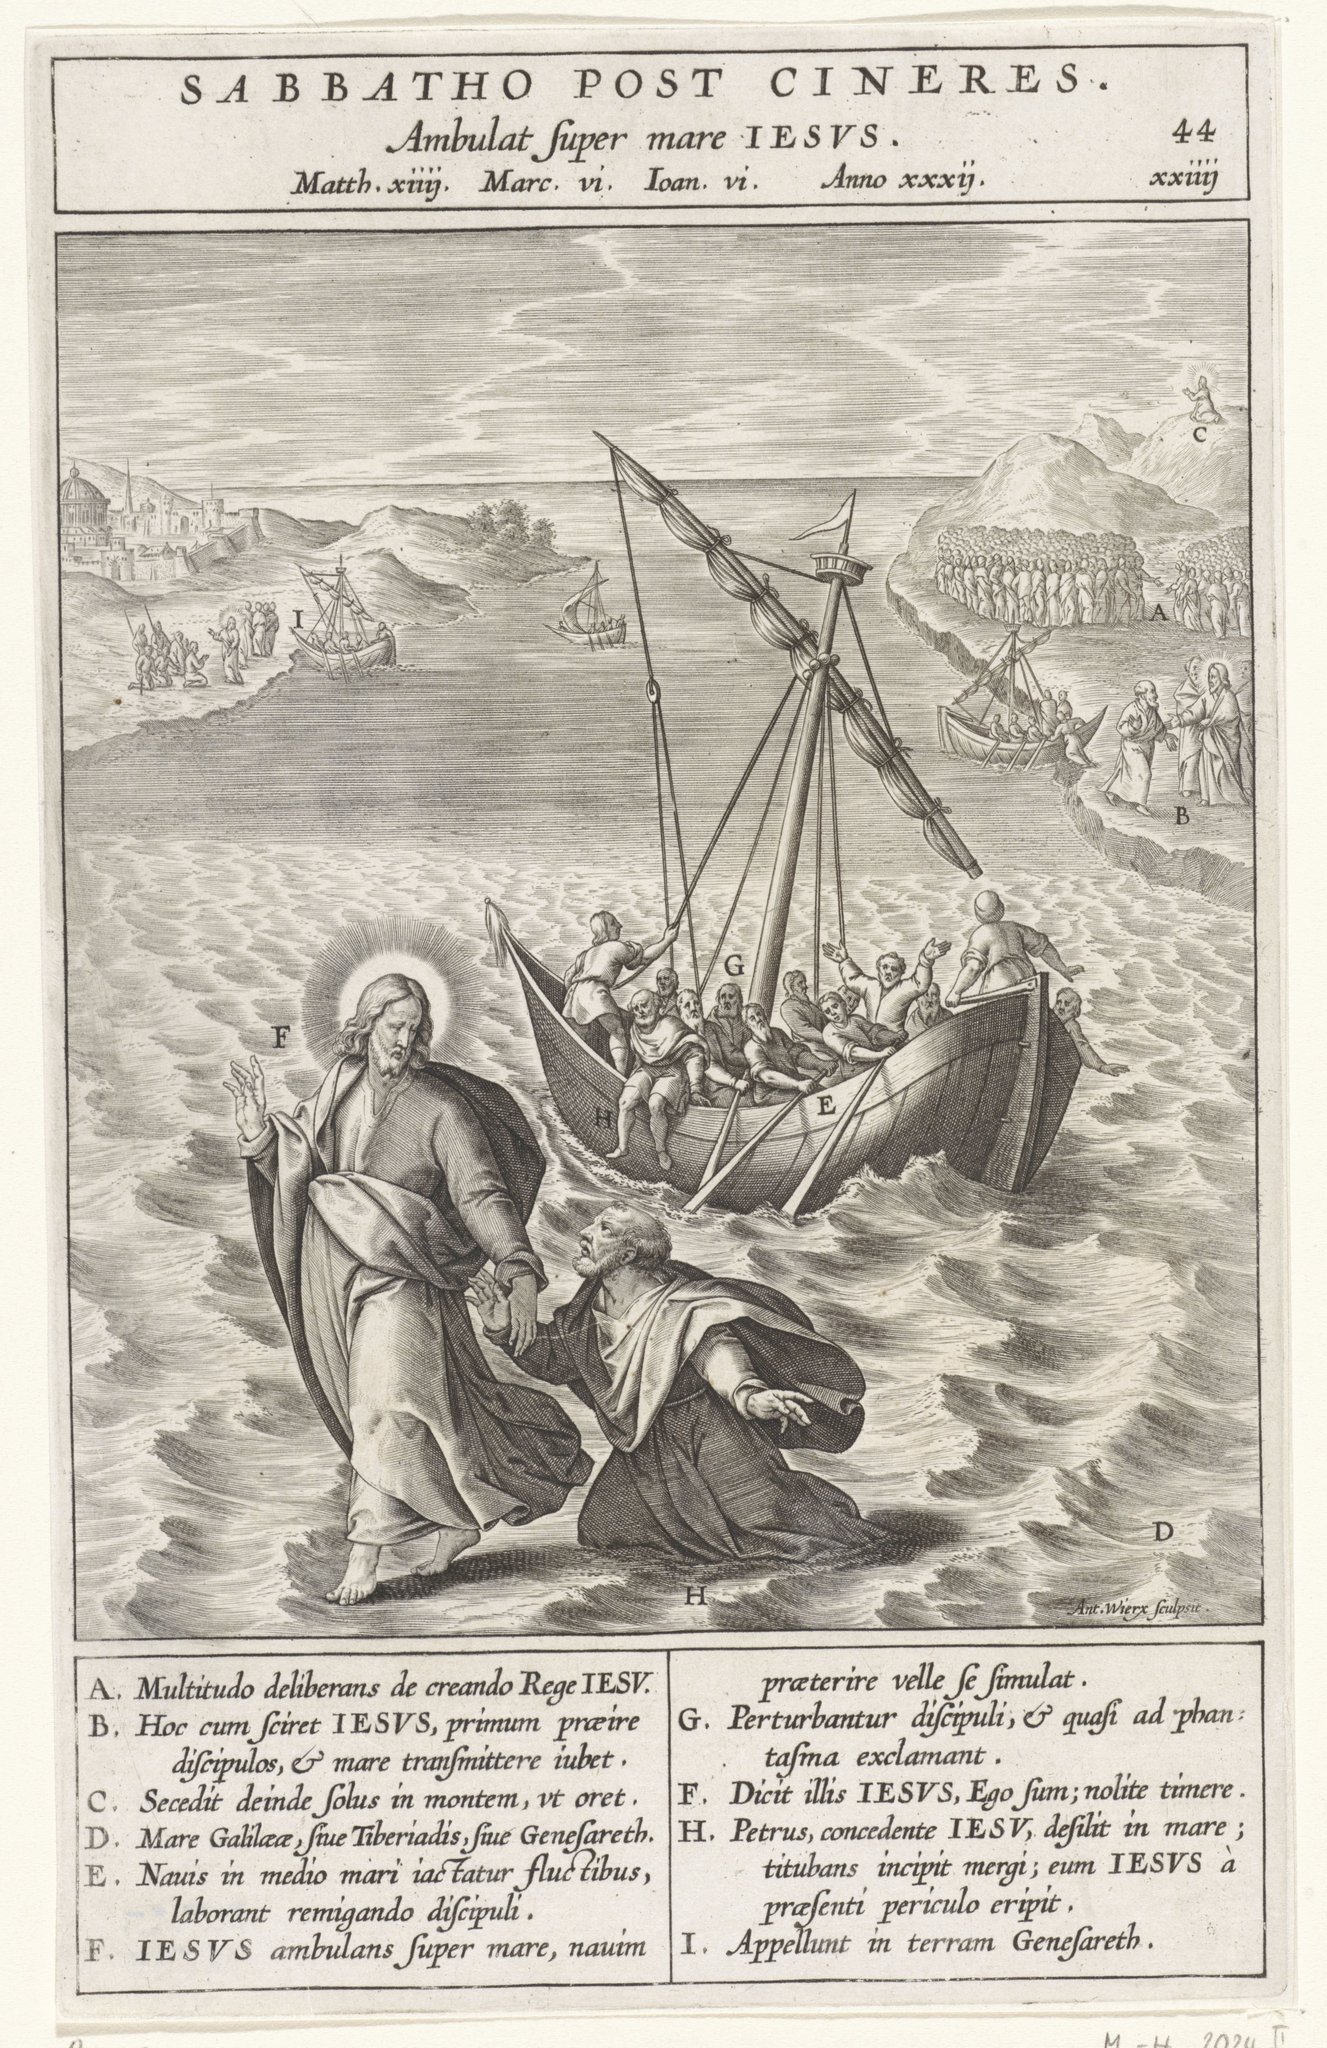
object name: print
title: Christus loopt over het water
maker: antonie wierix (ii)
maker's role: draughtsman, print maker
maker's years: 1555-1604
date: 1593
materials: paper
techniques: engraving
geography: antwerp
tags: peter steps out of the boat and tries to walk on the water towards christ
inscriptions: collector's mark: Lugt 2165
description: Op het Meer van Galilea wordt de boot met de leerlingen van Christus door de golven geteisterd. Christus loopt over het meer naar hen toe en Petrus komt hem tegemoet. Bij verschillende elementen uit de voorstelling staan letters die corresponderen met de legenda in de marge.